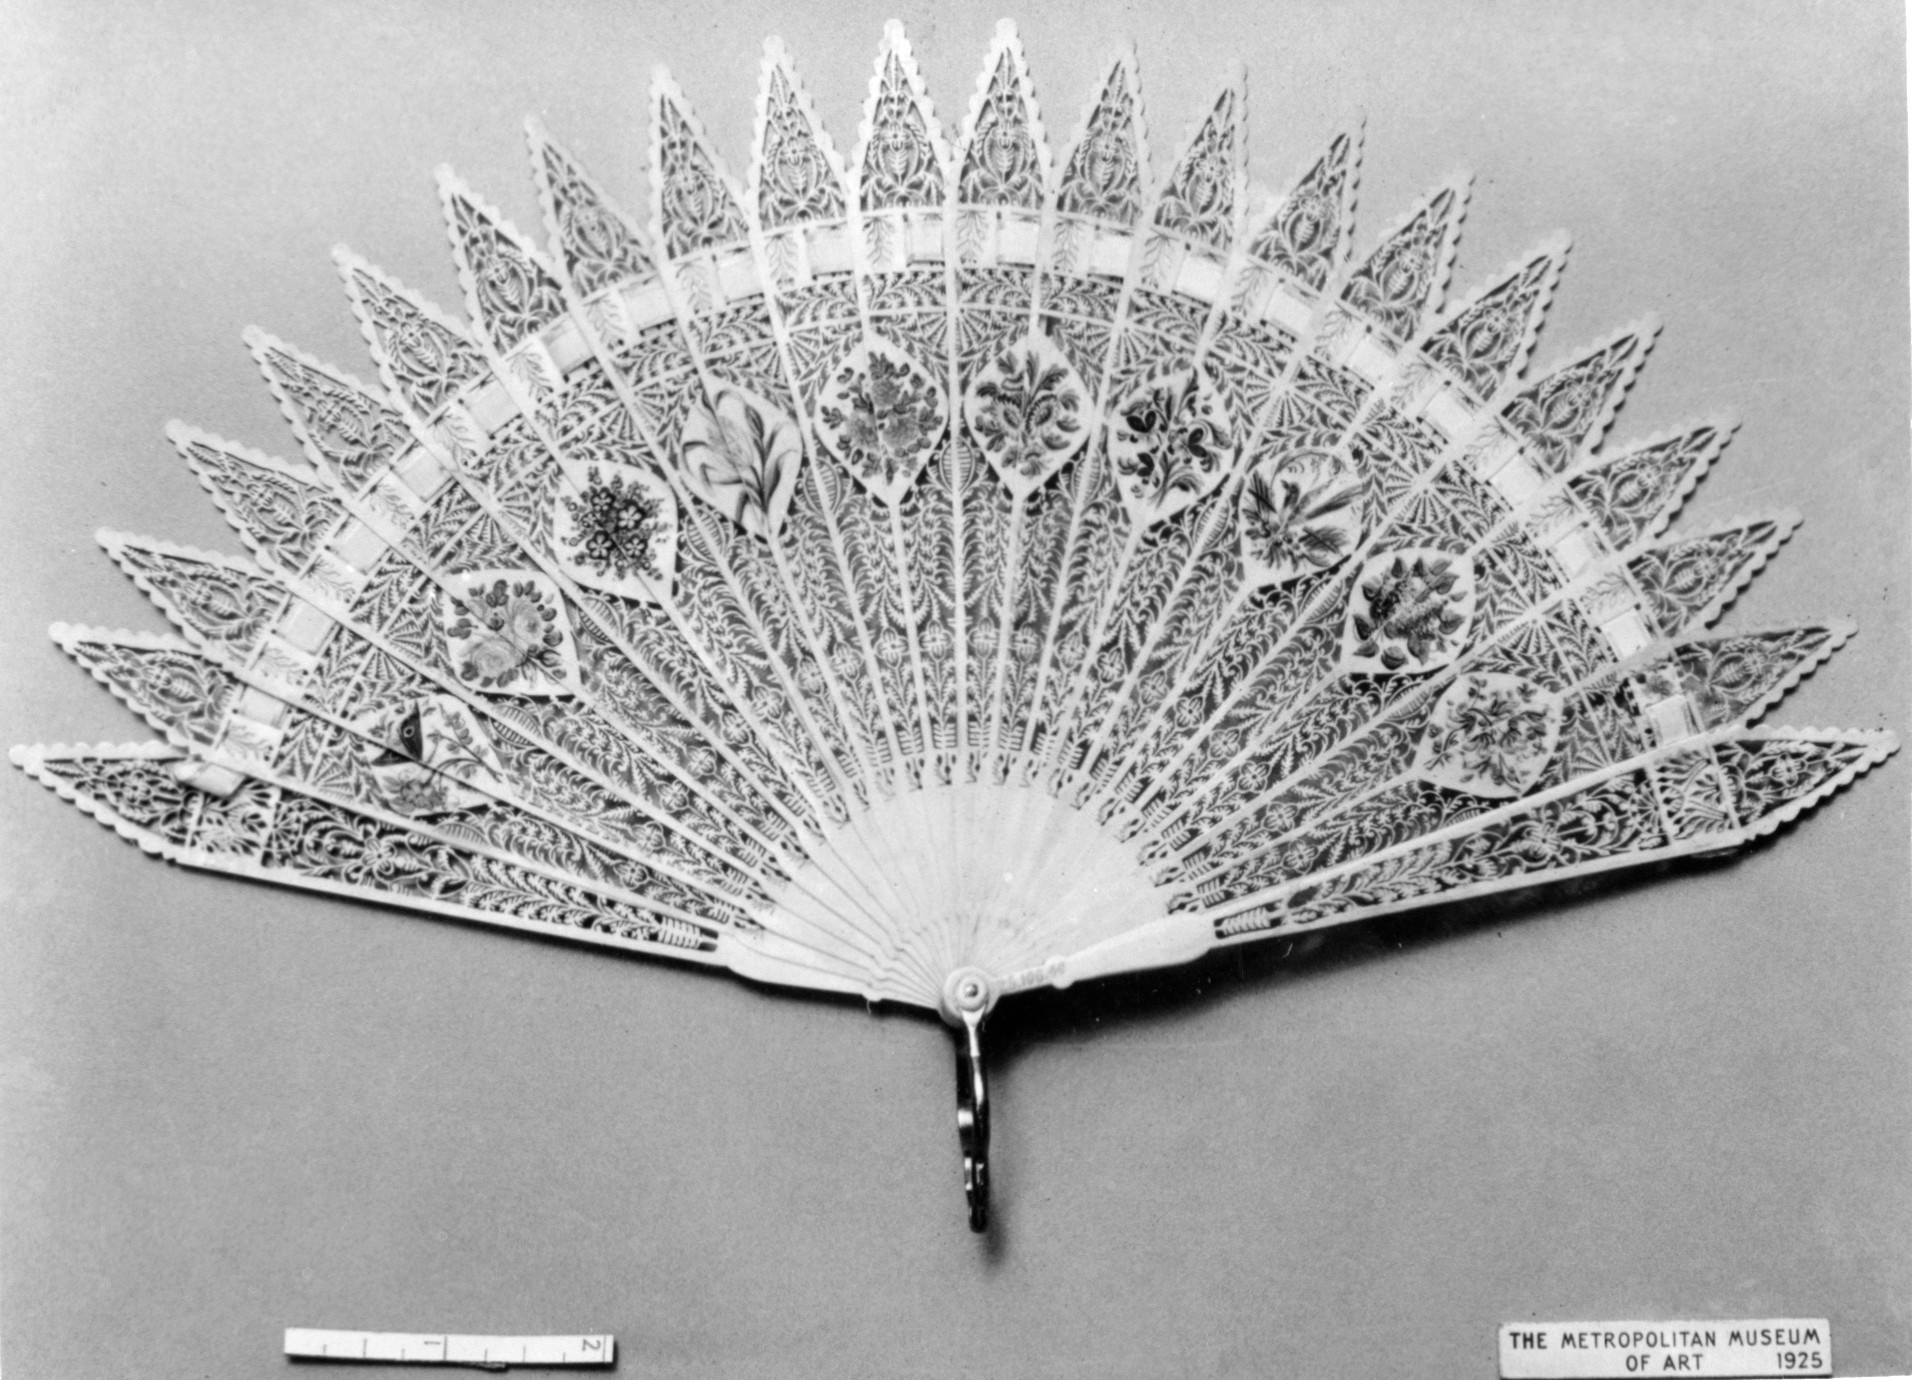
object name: fan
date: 1830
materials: ivory